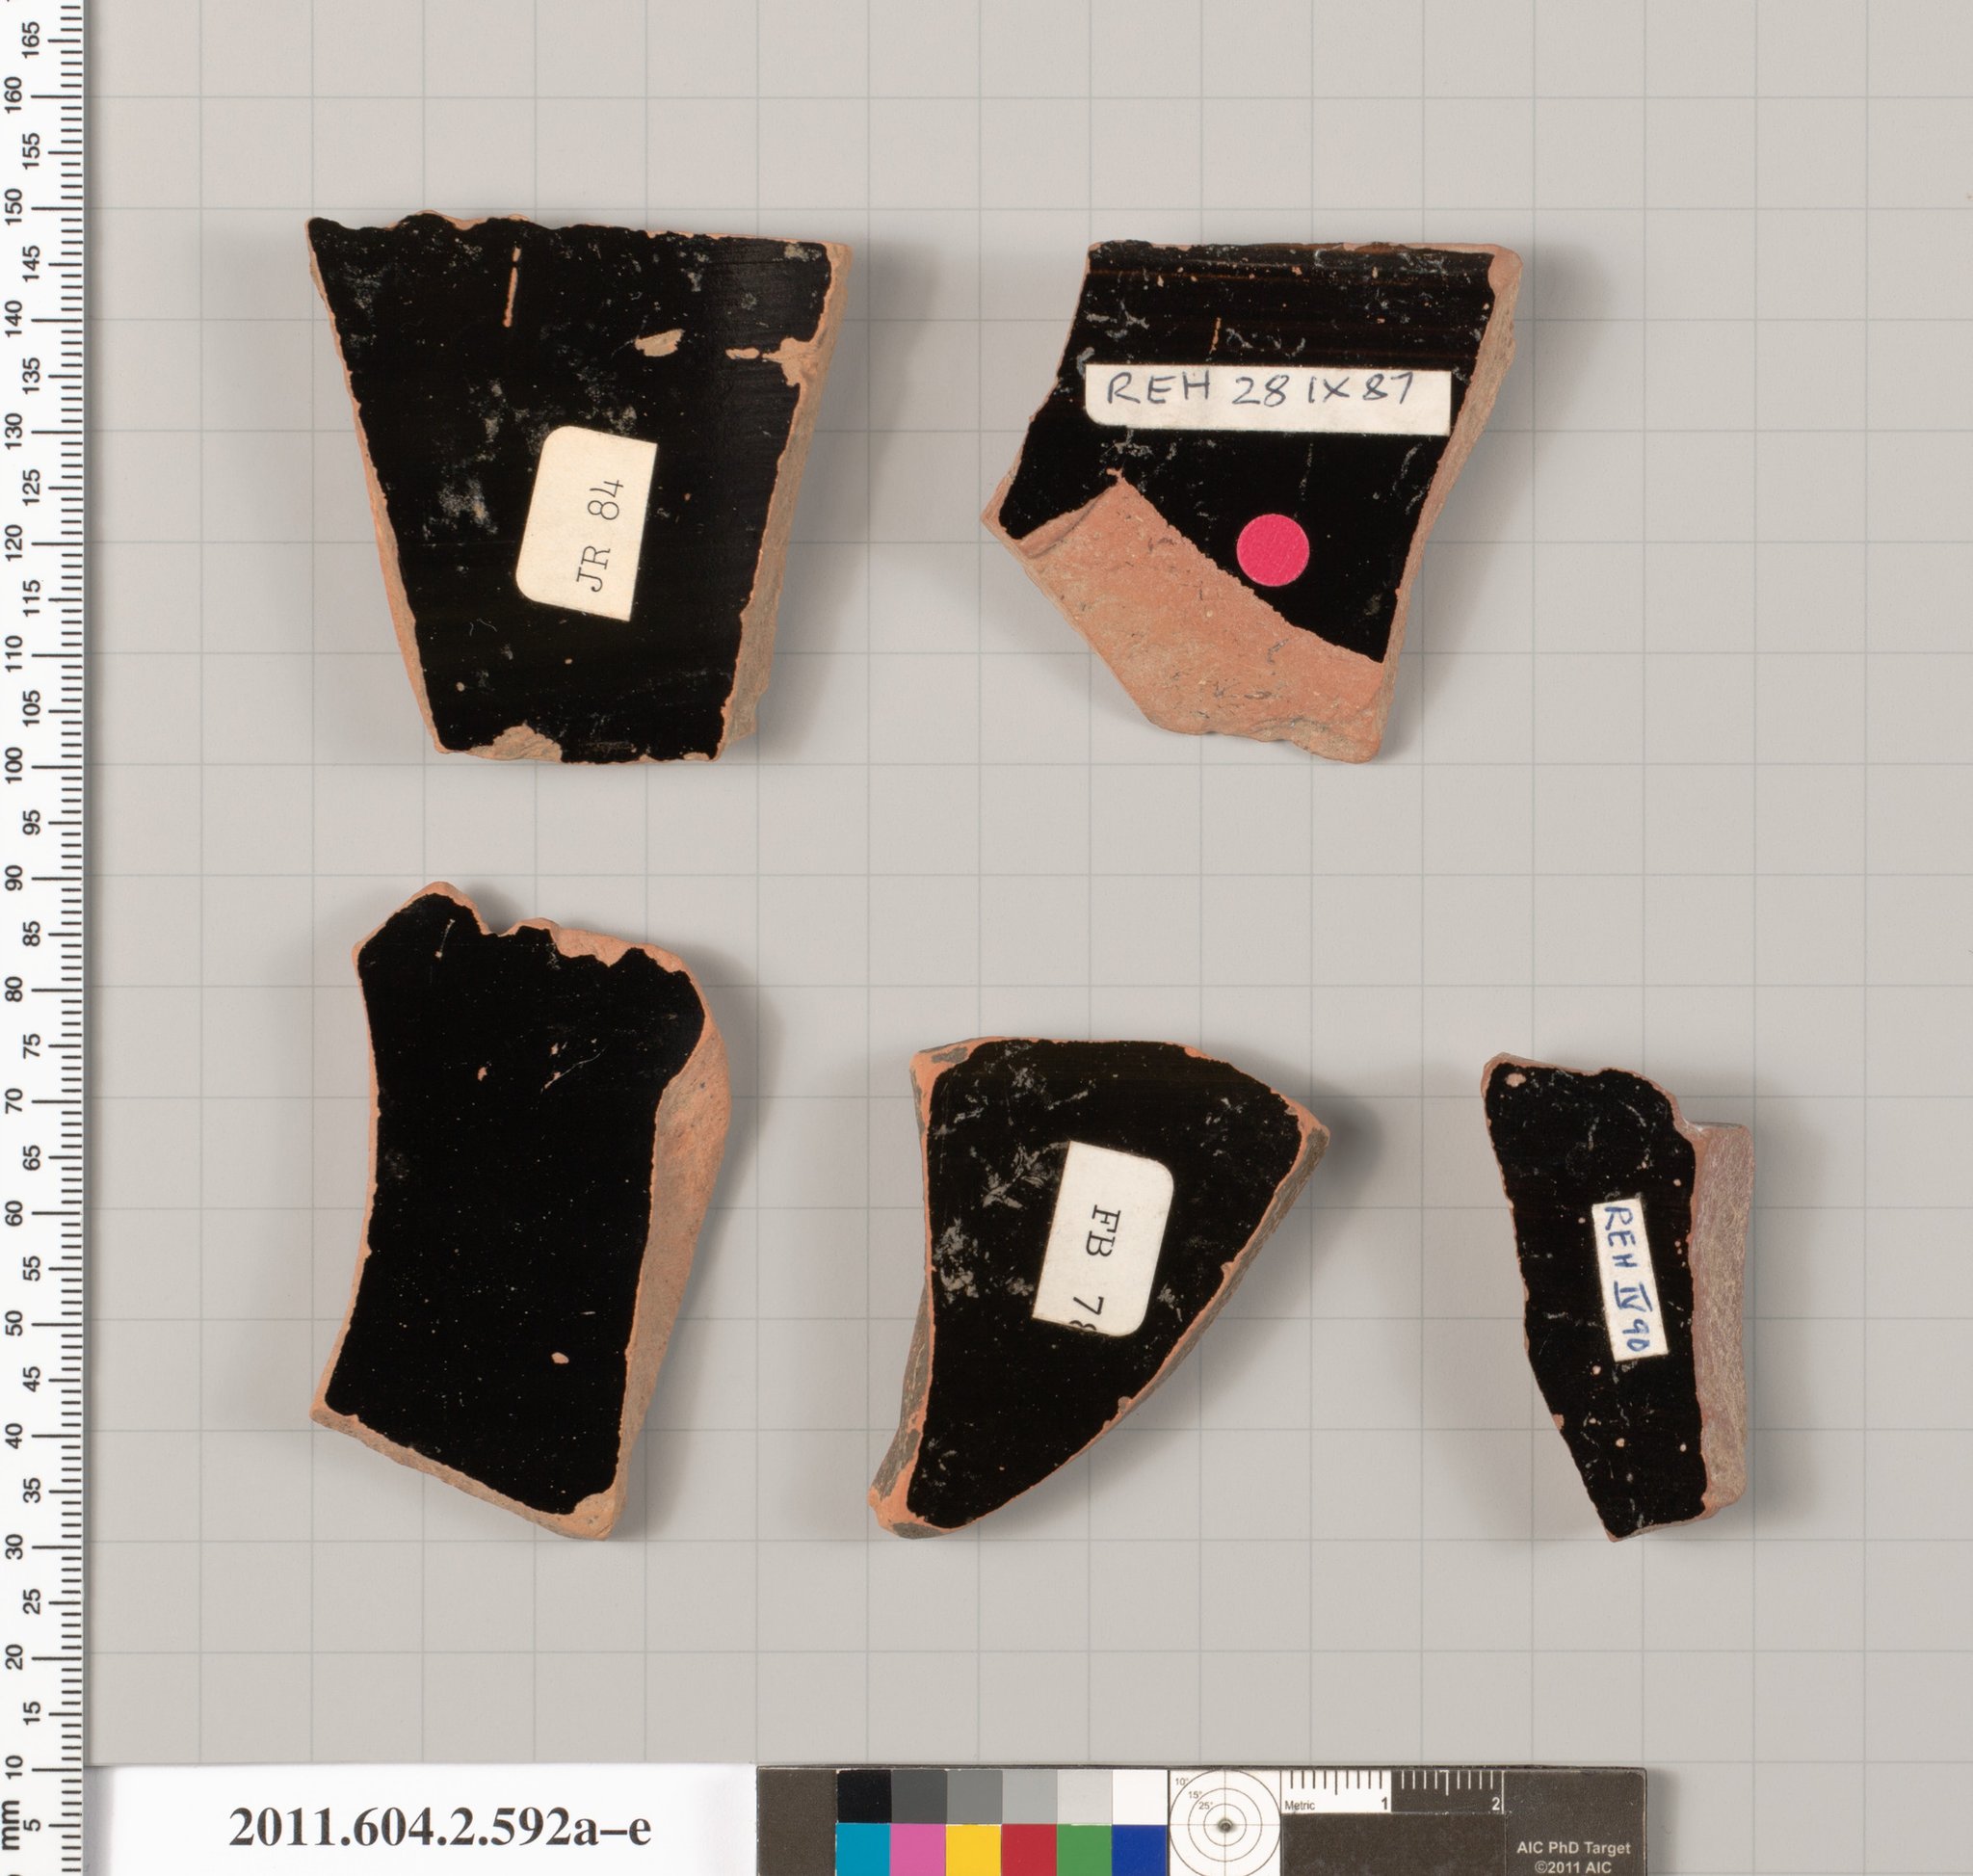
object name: column krater fragment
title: Terracotta fragments of column-kraters (bowls for mixing wine and water)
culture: greek, attic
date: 470-440 BCE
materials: terracotta